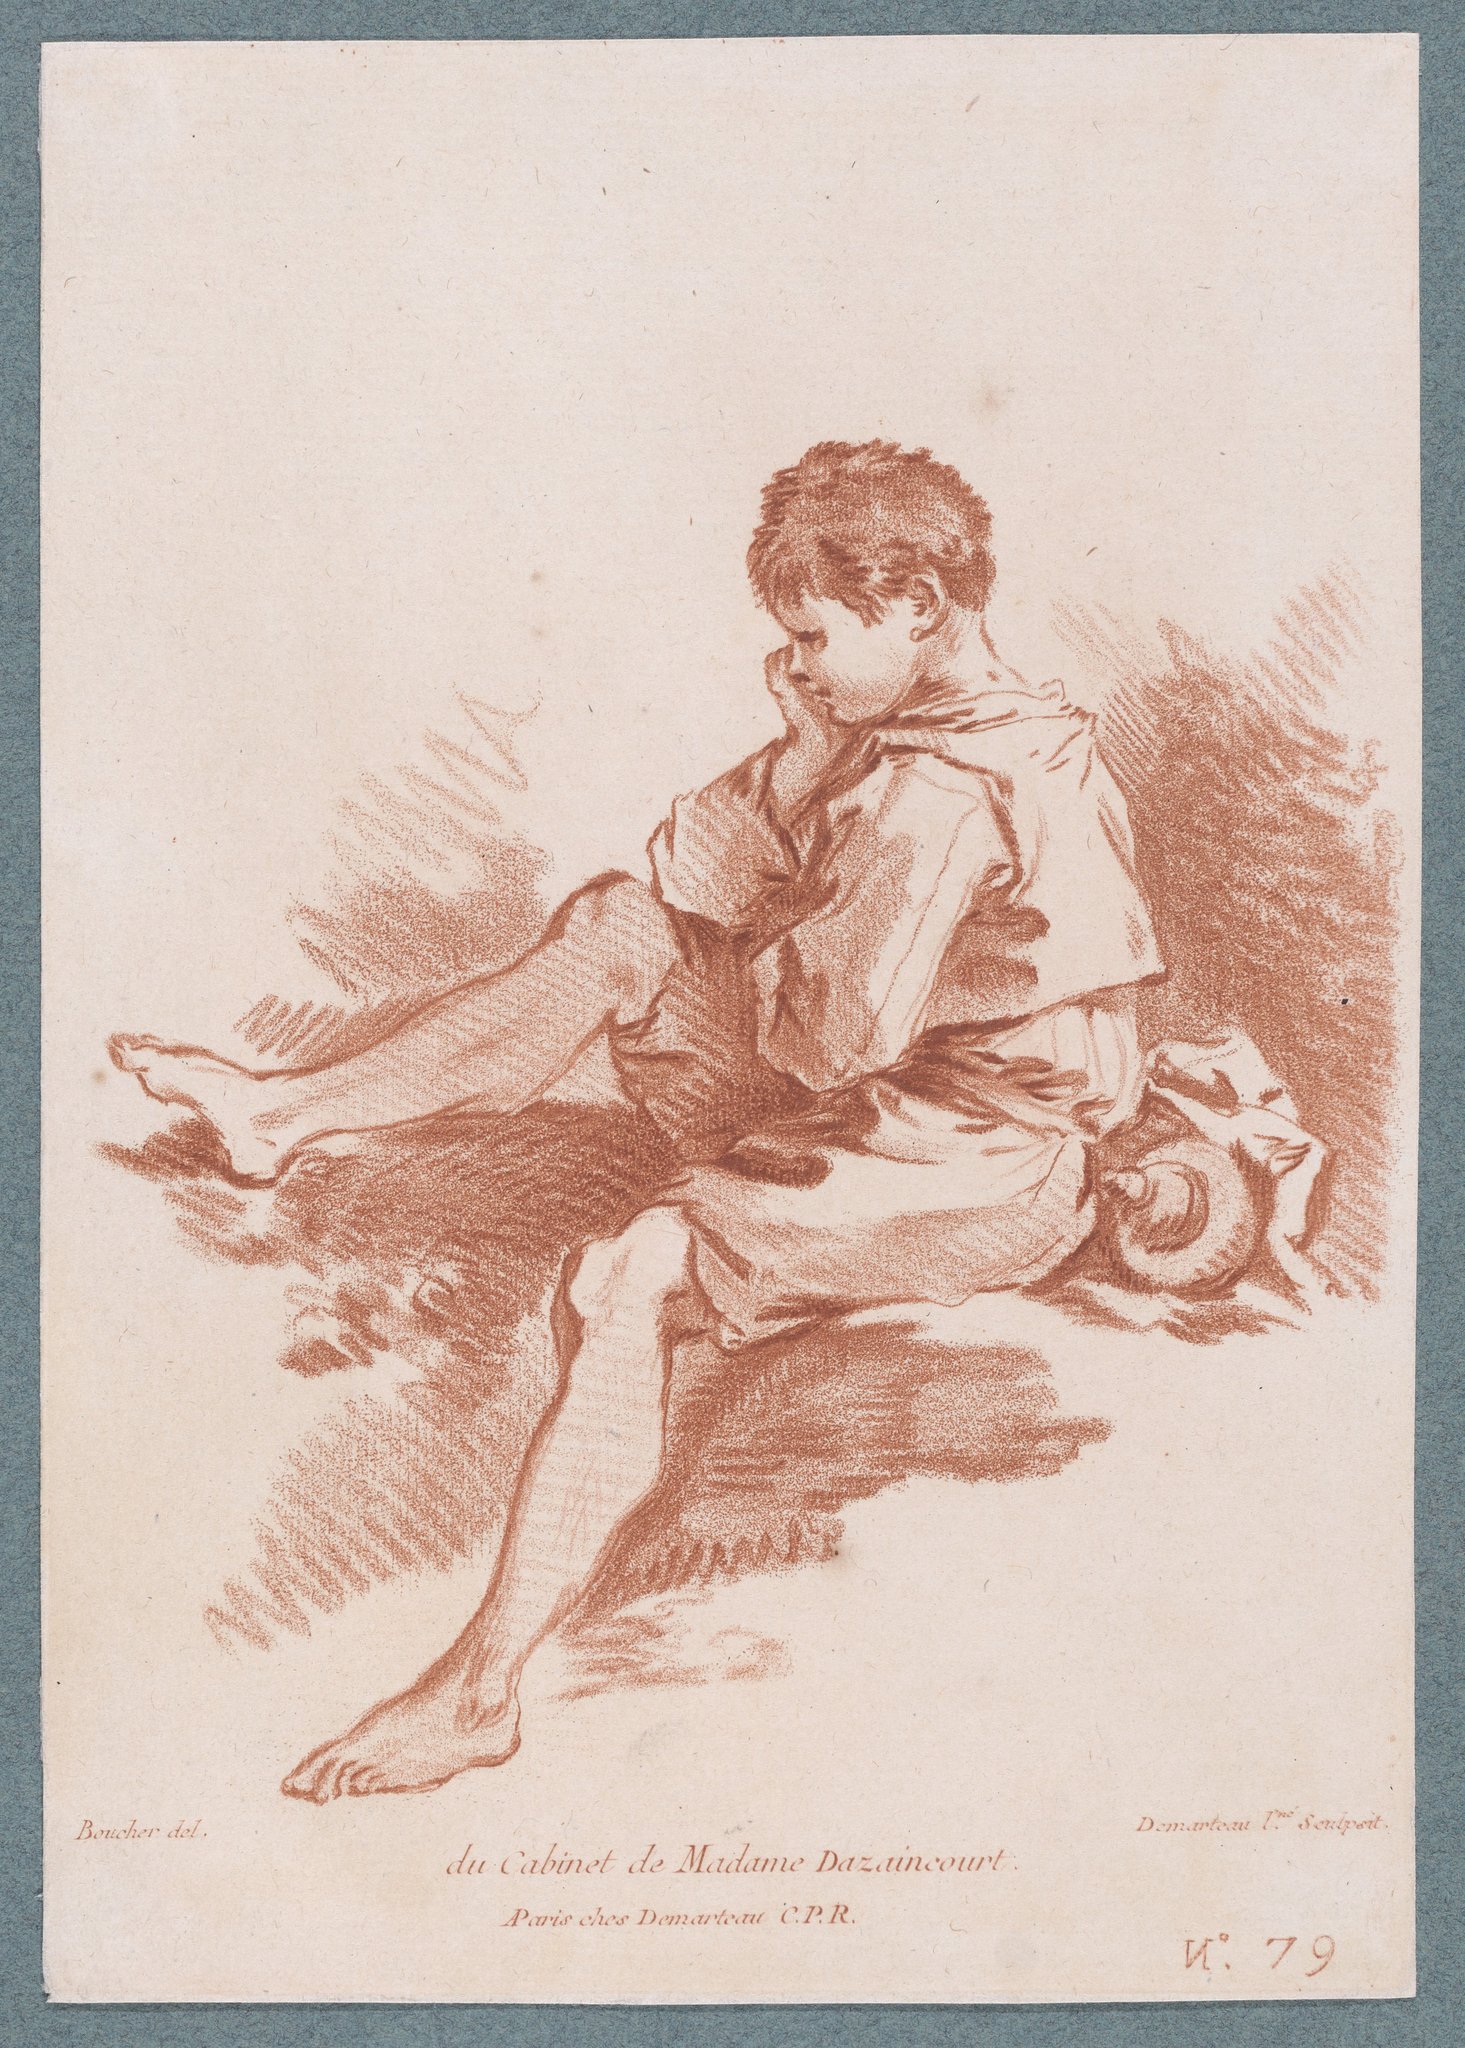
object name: print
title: Young peasant boy seated facing left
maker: gilles demarteau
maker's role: artist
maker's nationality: french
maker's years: 1722-1776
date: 1734-1766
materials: ink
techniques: printmaking, etching, printing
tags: boys